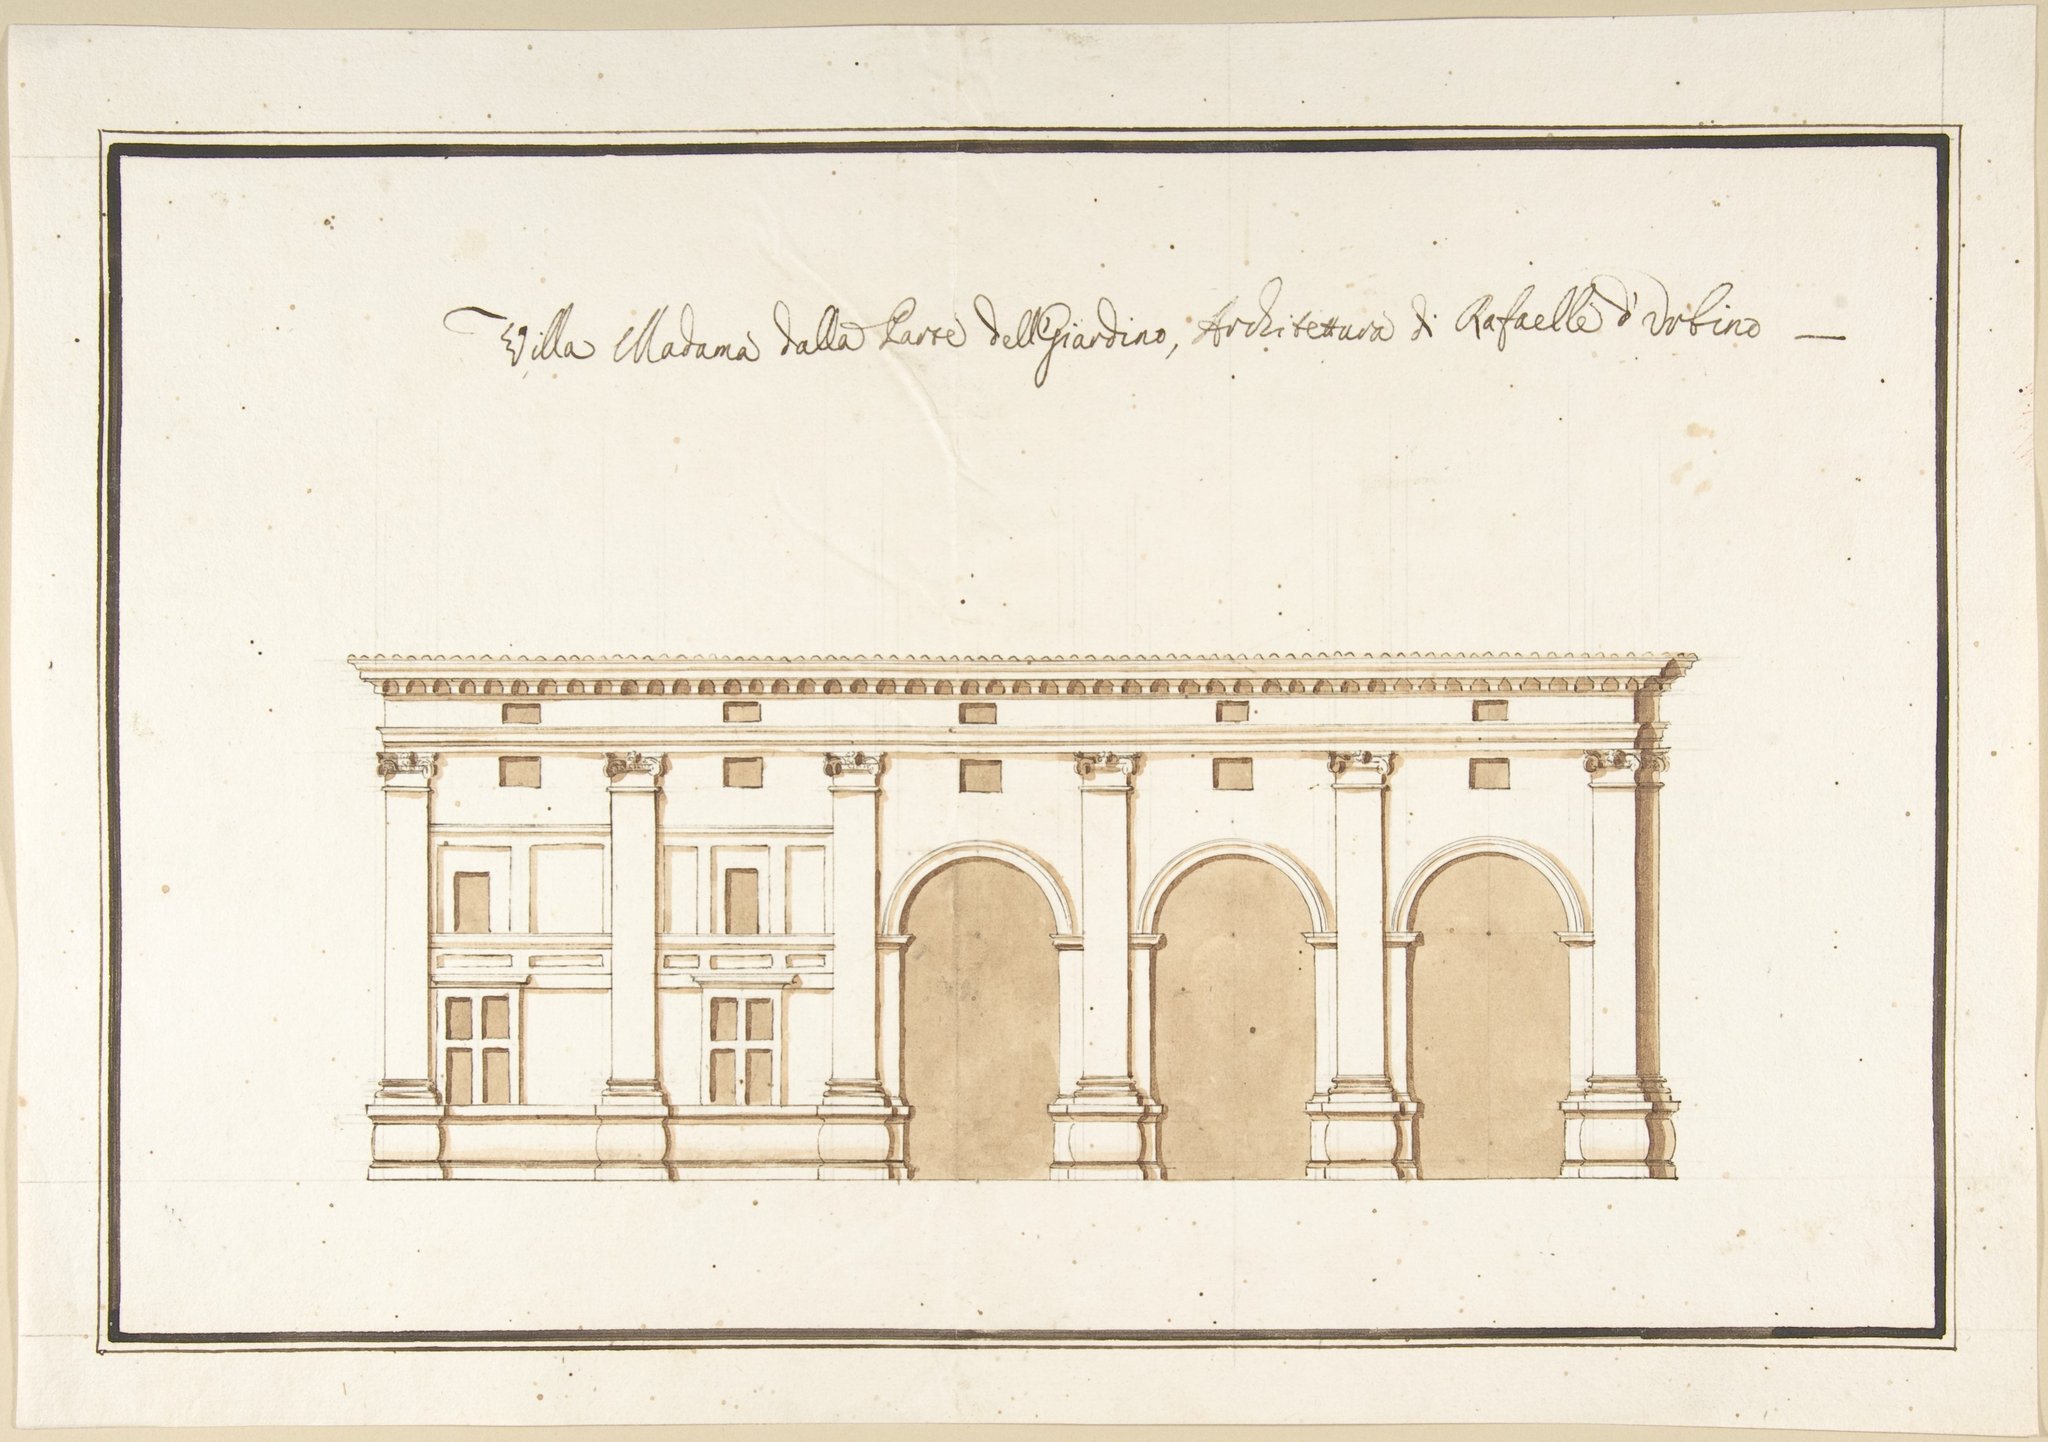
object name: drawing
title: Garden Elevation of the Villa Madama, Rome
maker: pietro paolo coccetti (cocchetti)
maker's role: artist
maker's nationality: italian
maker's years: 1710-1727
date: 1710-1727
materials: graphite, ink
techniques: brush, pen, wash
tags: architecture,buildings